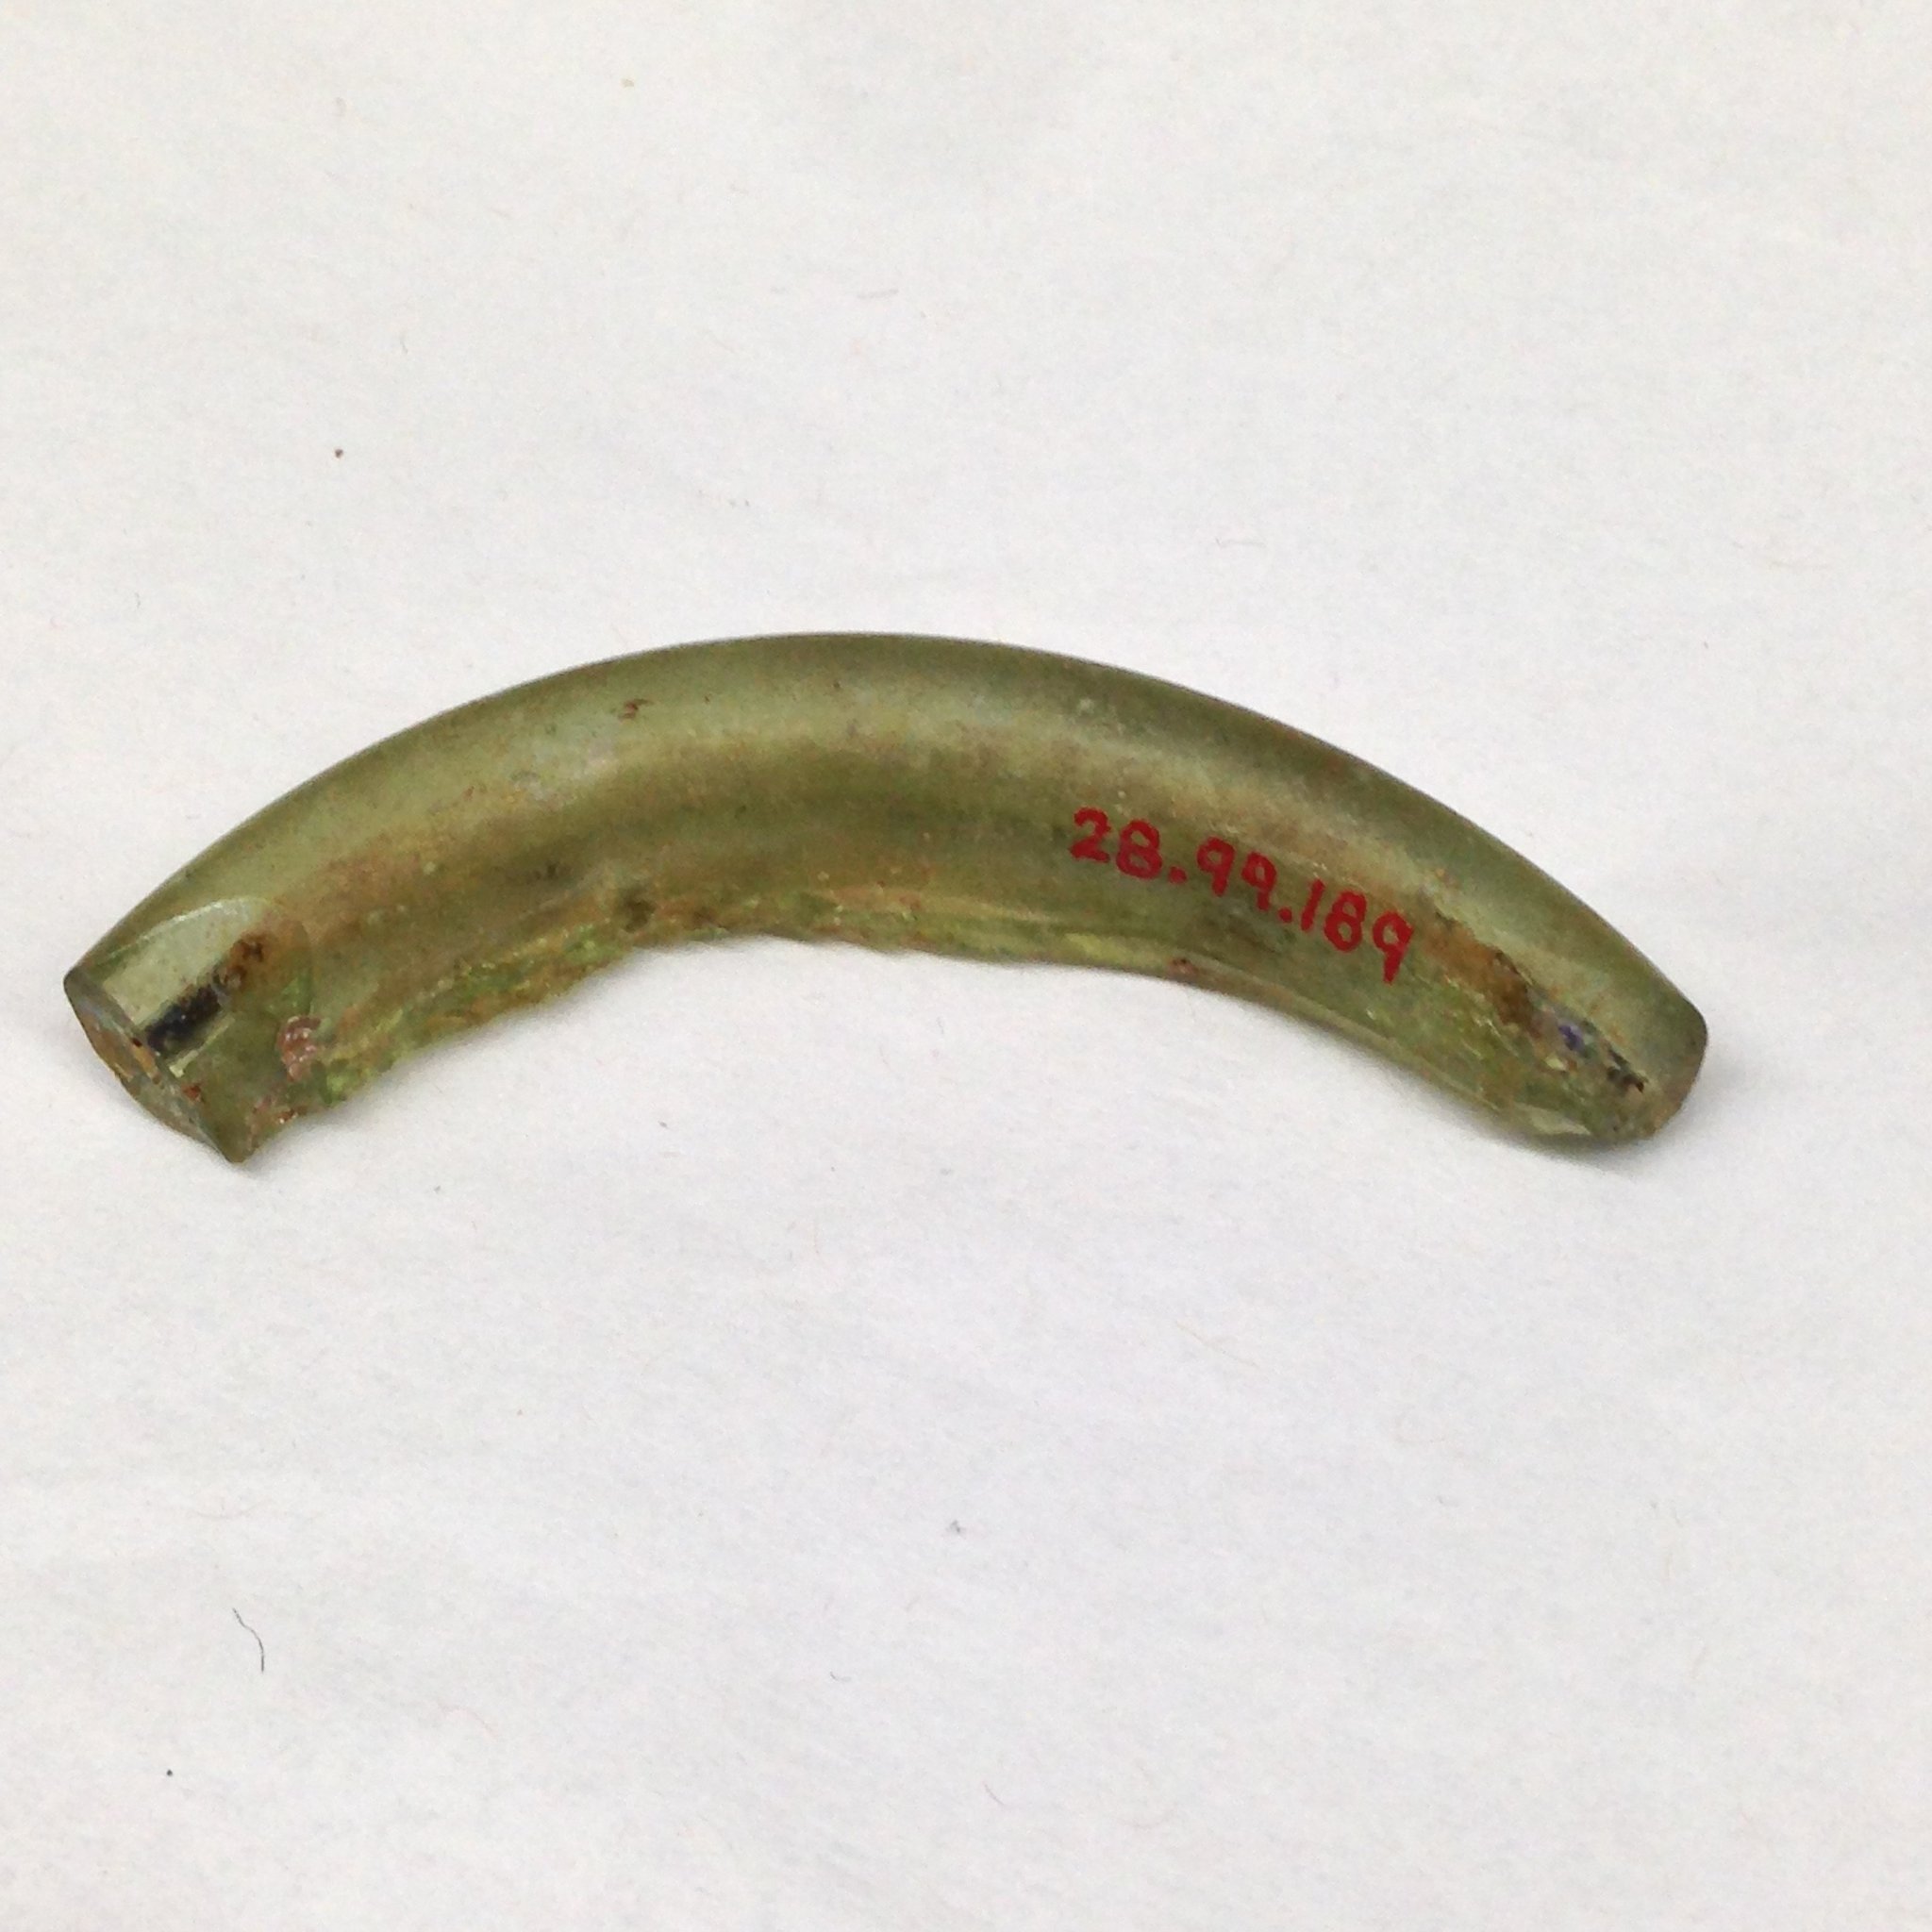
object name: fragment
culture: european or middle eastern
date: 1150-1250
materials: ceramic, glass